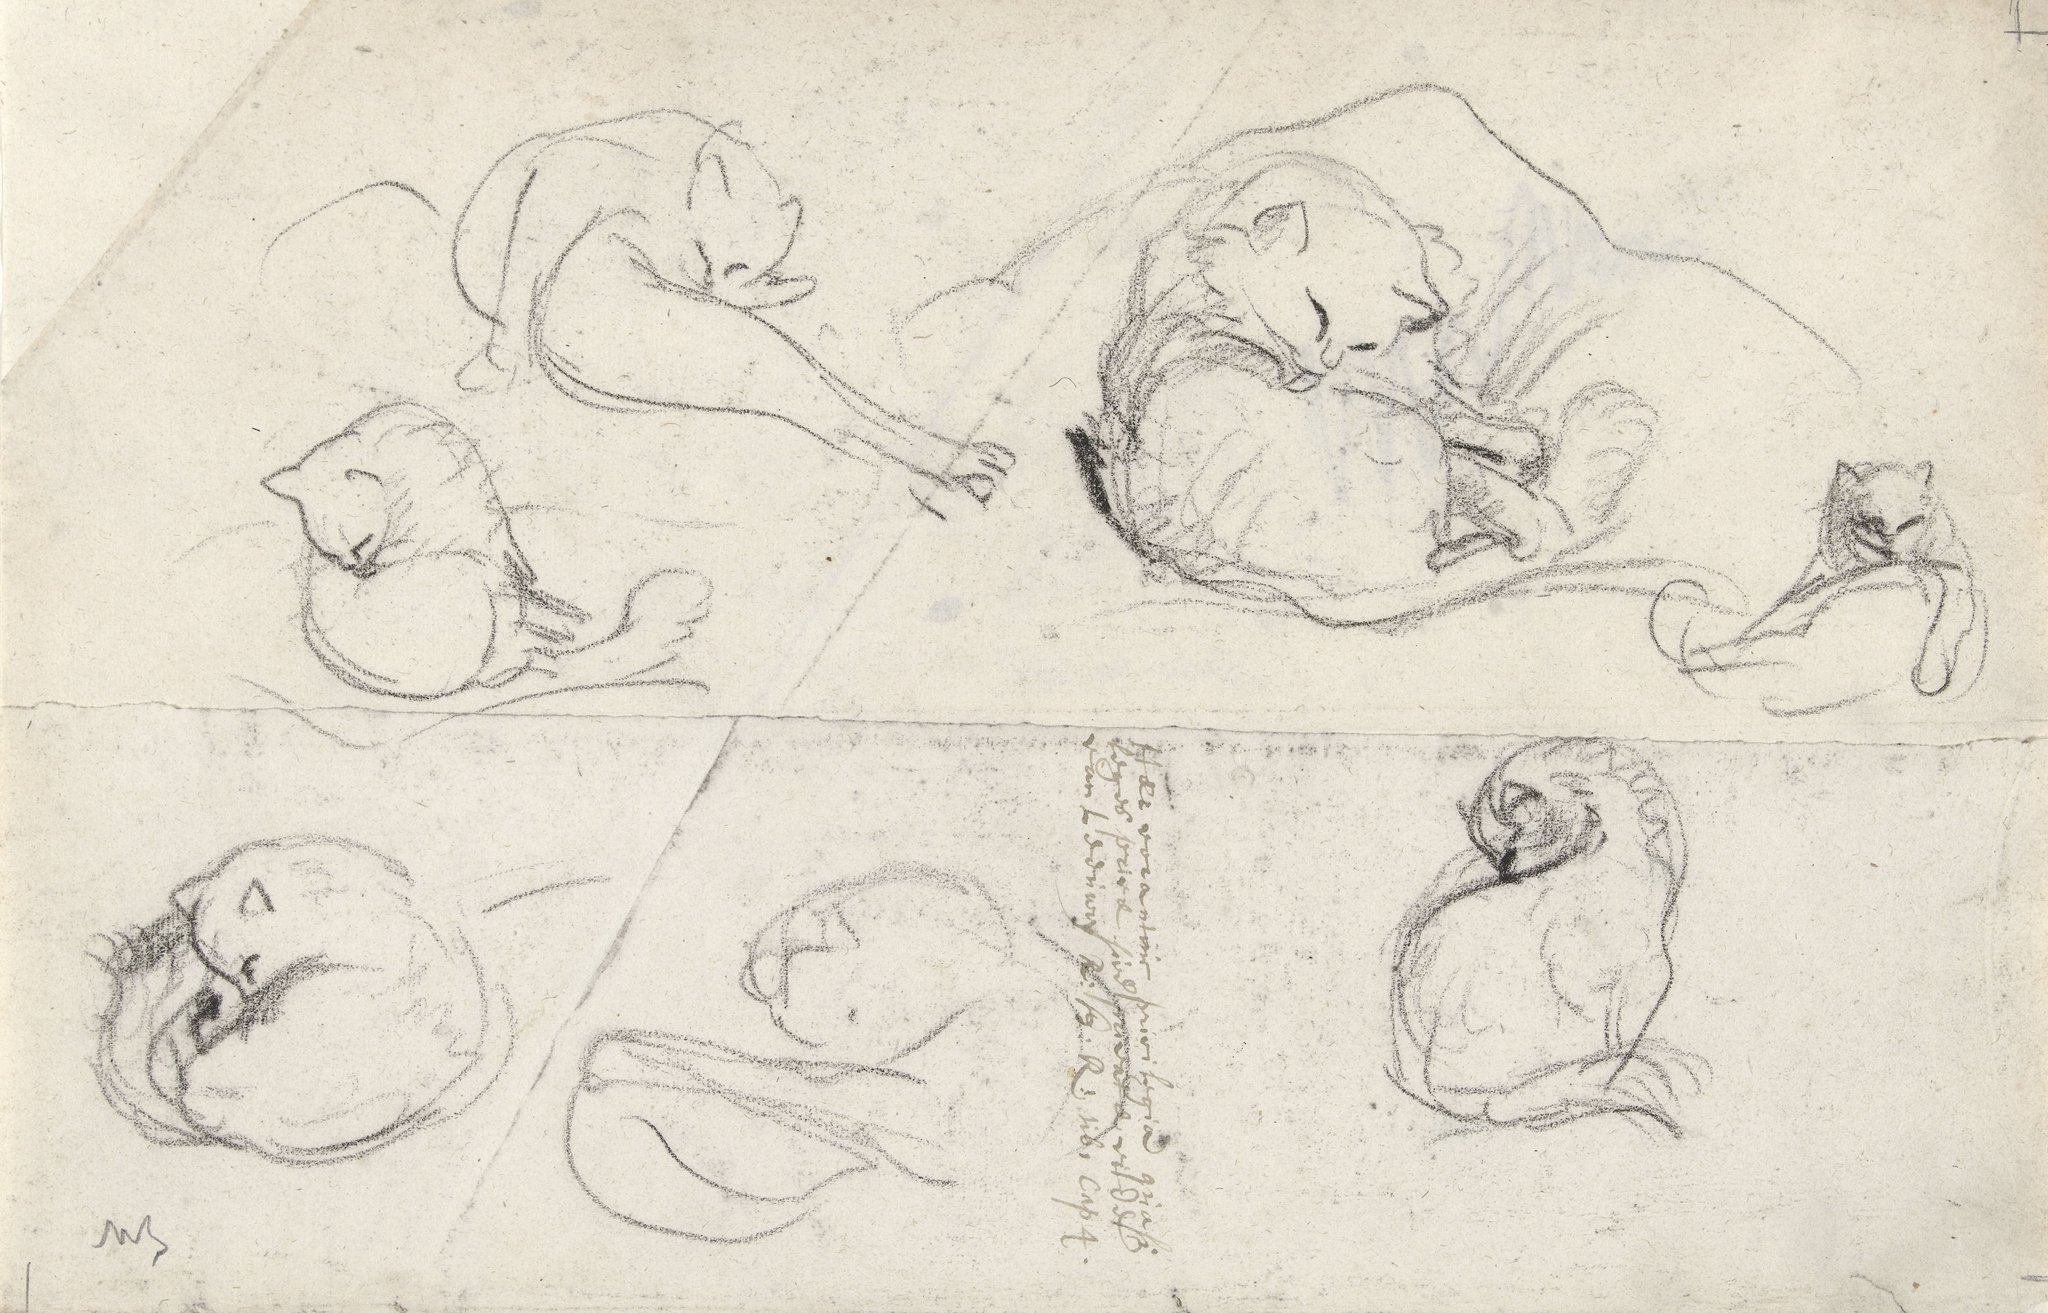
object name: drawing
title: Schetsen van een poes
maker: marius bauer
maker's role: draughtsman, print maker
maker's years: 1867-1932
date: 1877-1932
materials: chalk, paper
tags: cat